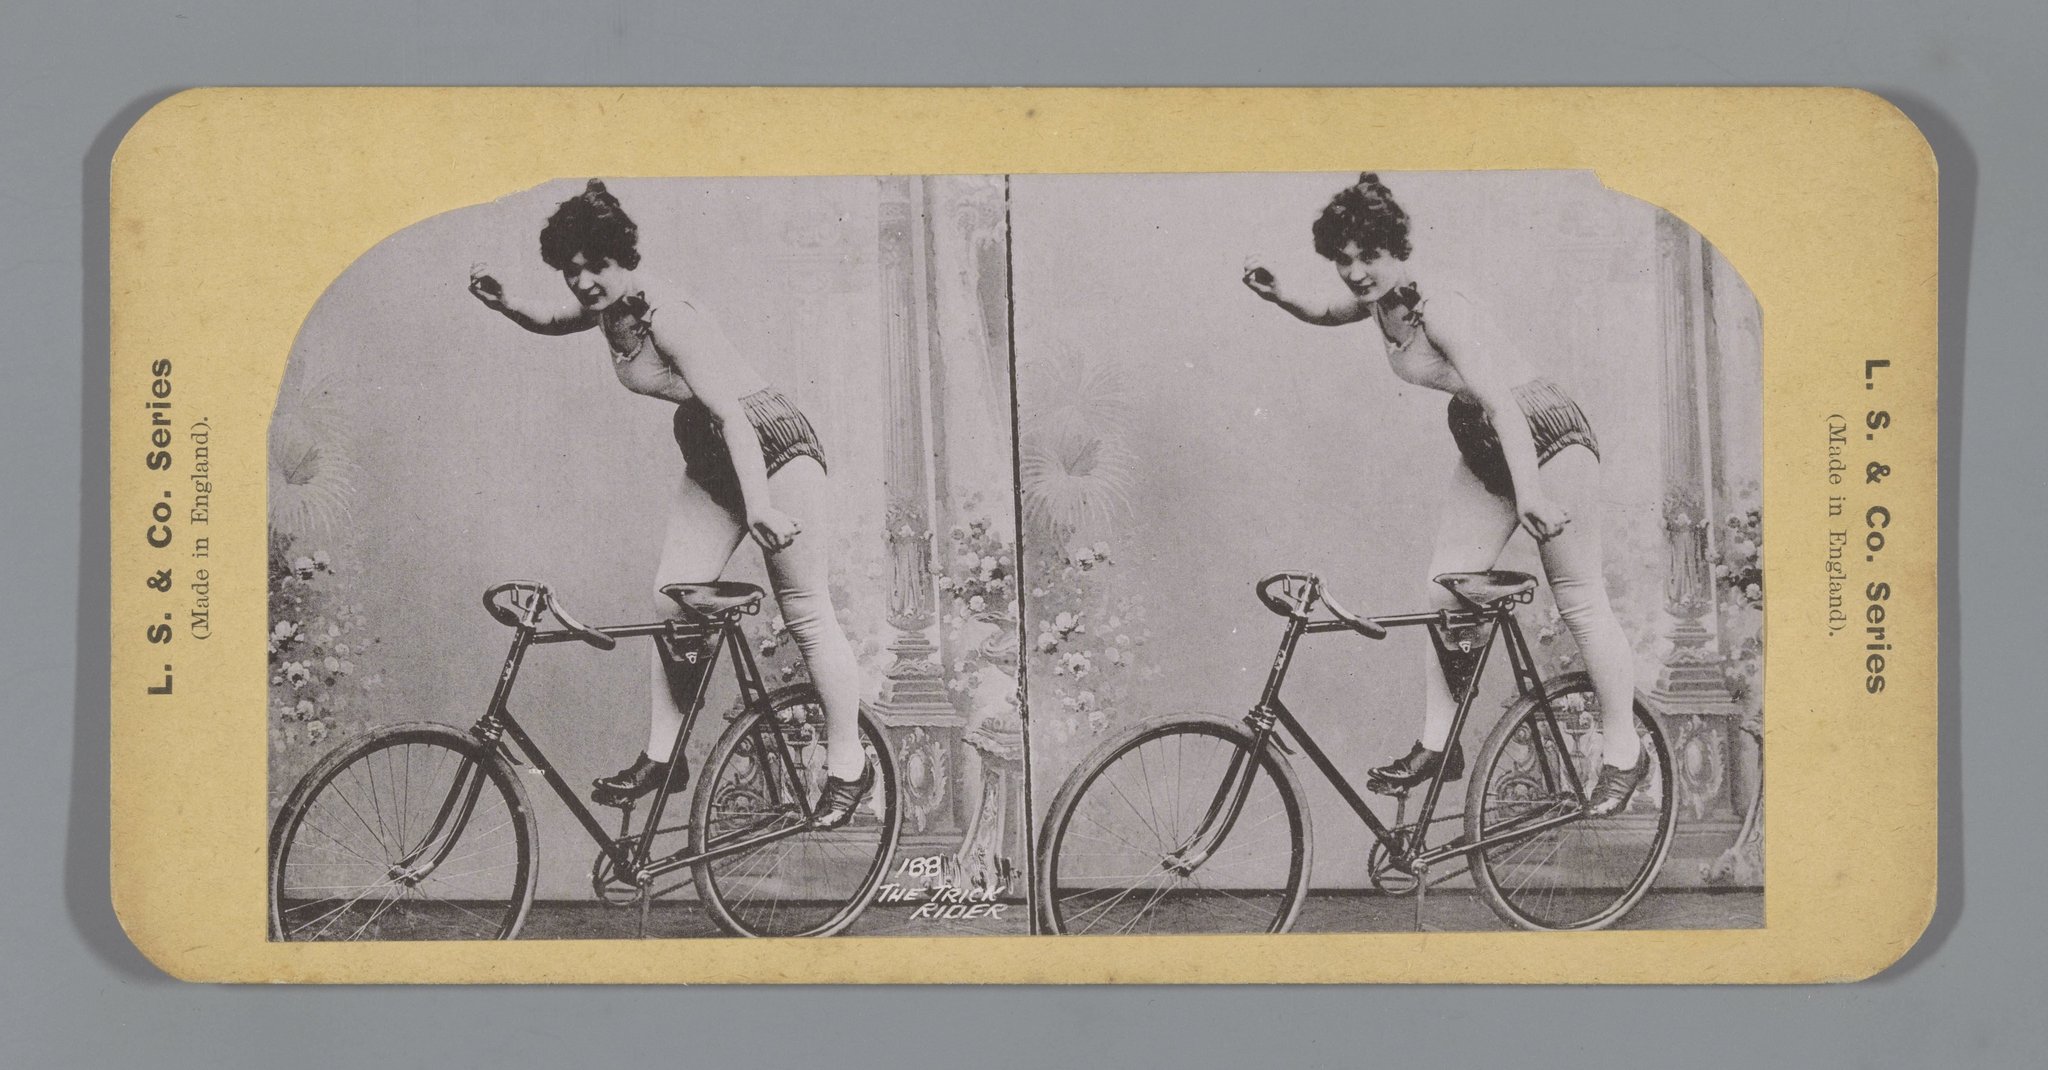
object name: photomechanical print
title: The Trick Rider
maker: Anonymous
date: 1870-1890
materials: cardboard, photographic support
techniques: photograph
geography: london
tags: adult woman, bicycle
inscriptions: retailer's mark: ‘JK’, number: ‘188’